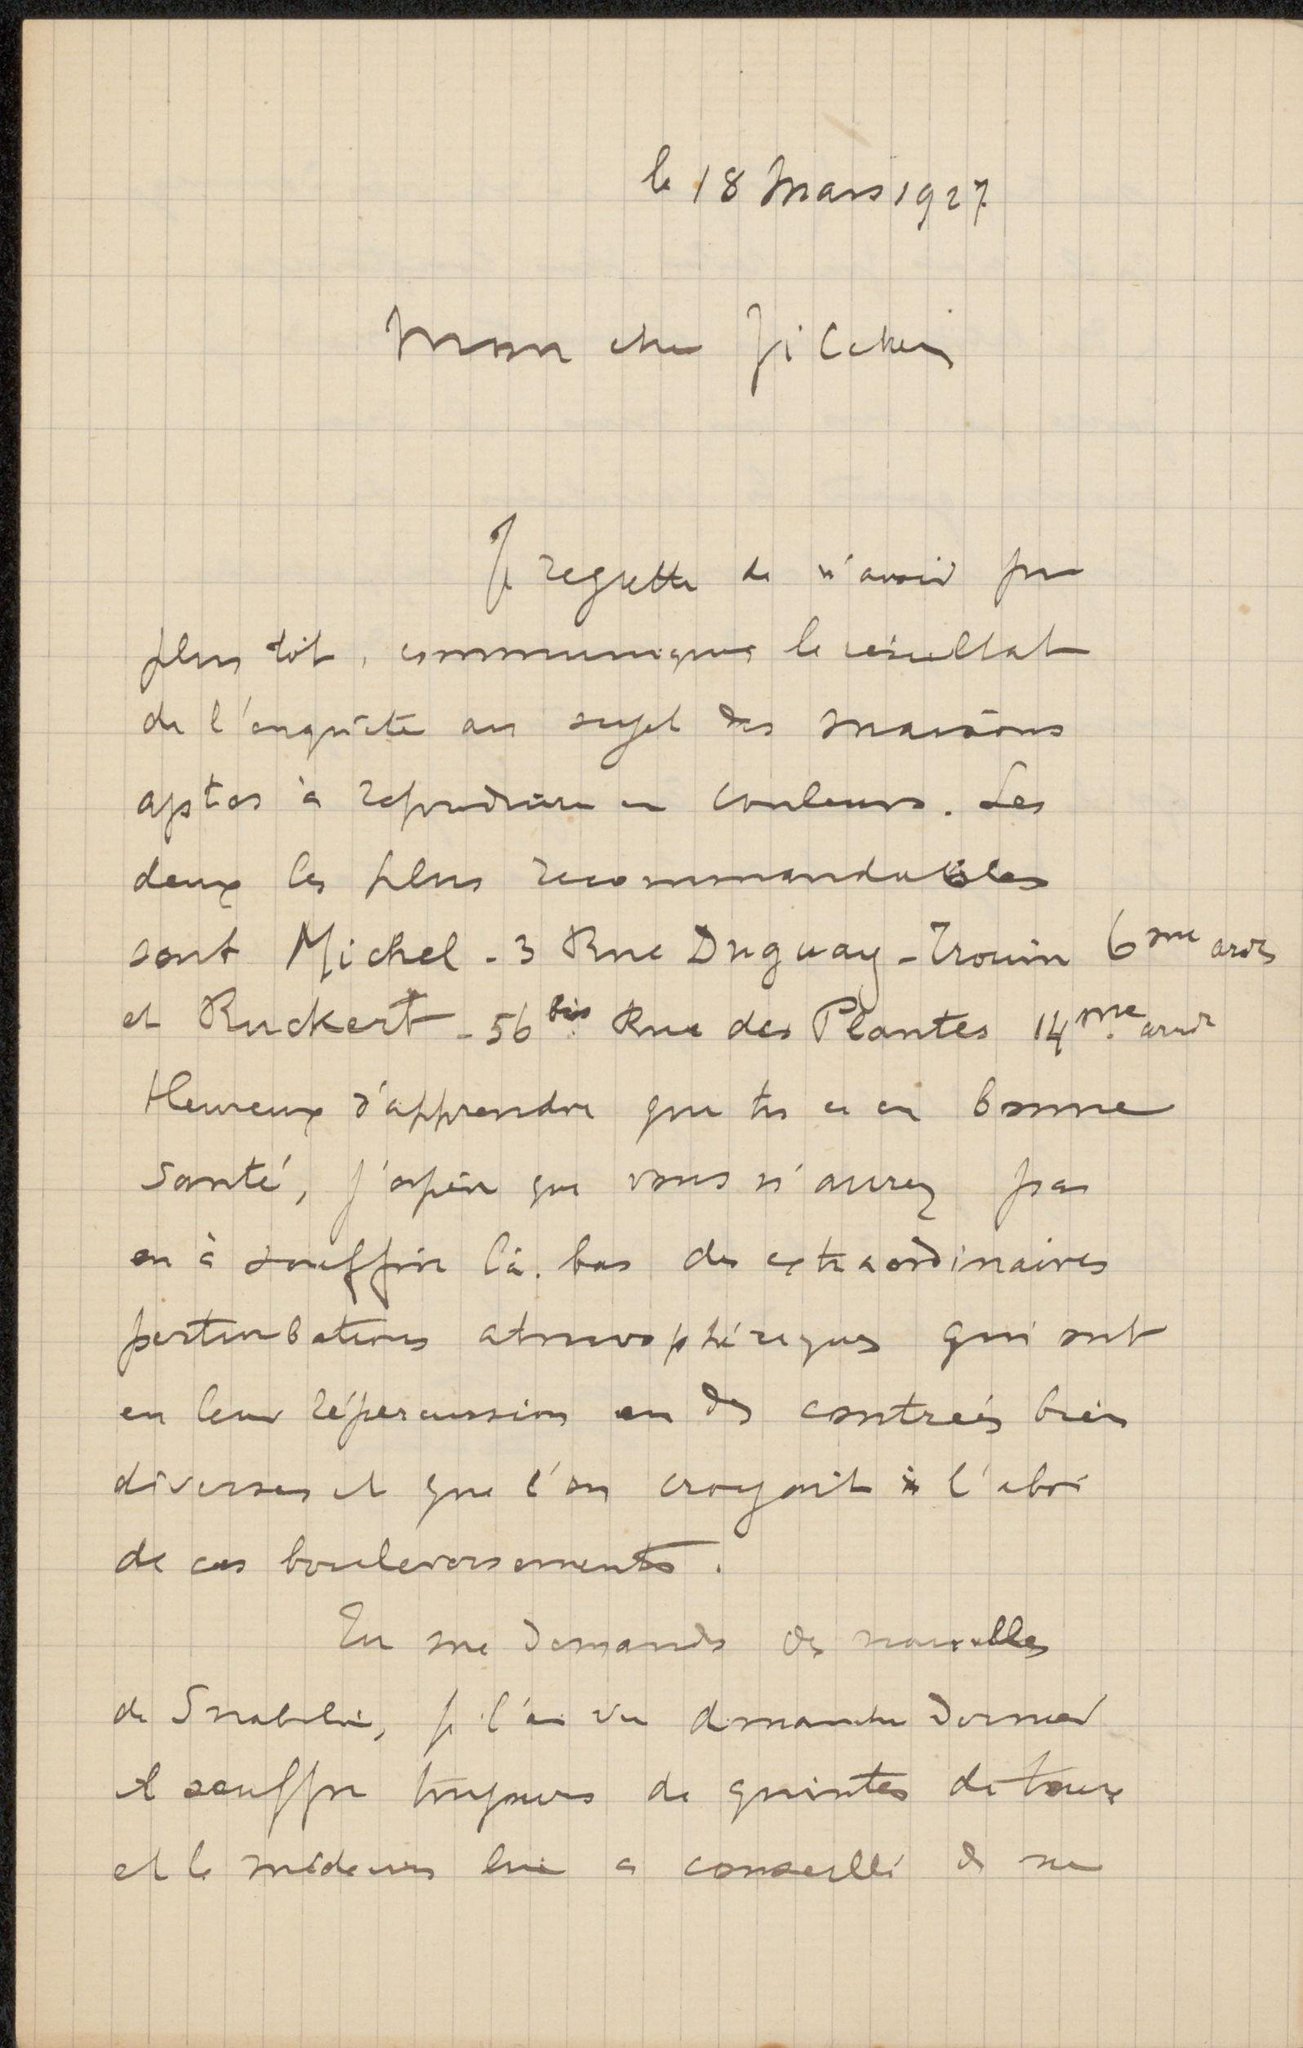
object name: letter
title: Brief aan Philip Zilcken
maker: charles destrée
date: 1927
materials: ink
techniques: pen, writing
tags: charles snabilié, painter, draughtsman, philip zilcken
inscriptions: collector's mark: ‘RPK’